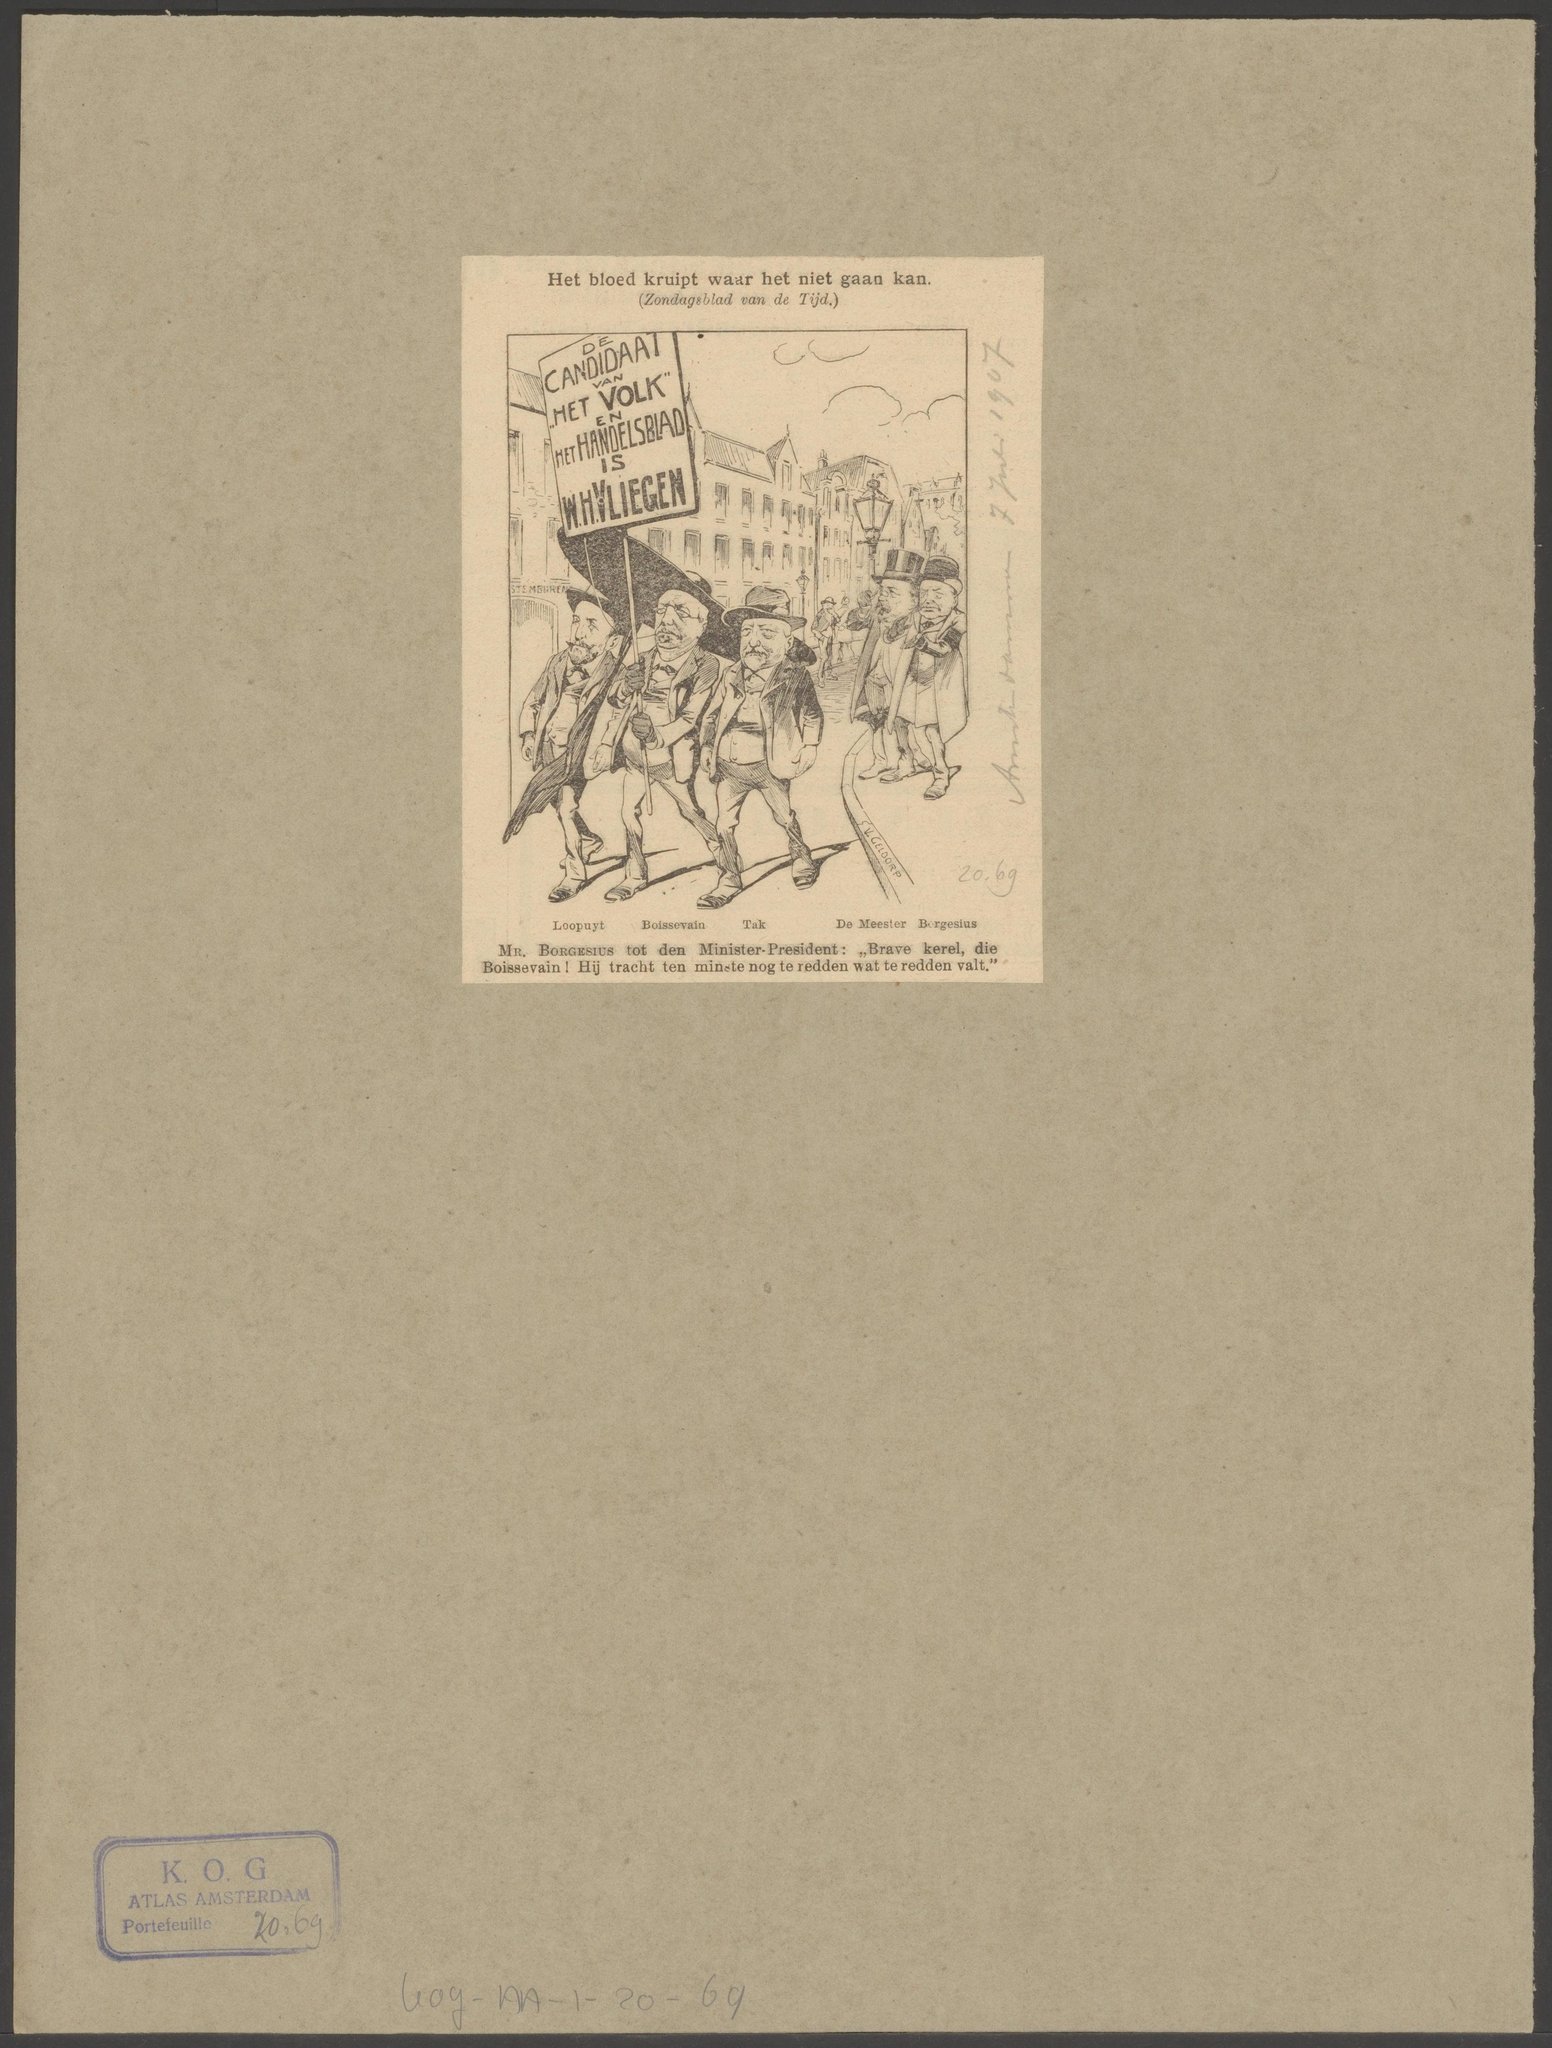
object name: photomechanical print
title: Drie mannen stappen met een verkiezingsleuze door de straten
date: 1907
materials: paper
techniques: letterpress printing, line block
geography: netherlands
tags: the hague, politician, netherlands, charles boissevain, middelburg, pieter lodewijk tak, voting propaganda, politician, e.g. party leader, political caricatures and satires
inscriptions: collector's mark: Lugt 1641b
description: Onderwerpsrubriek binnen de Atlas Amsterdam: Verkiezingen Tweede Kamer.